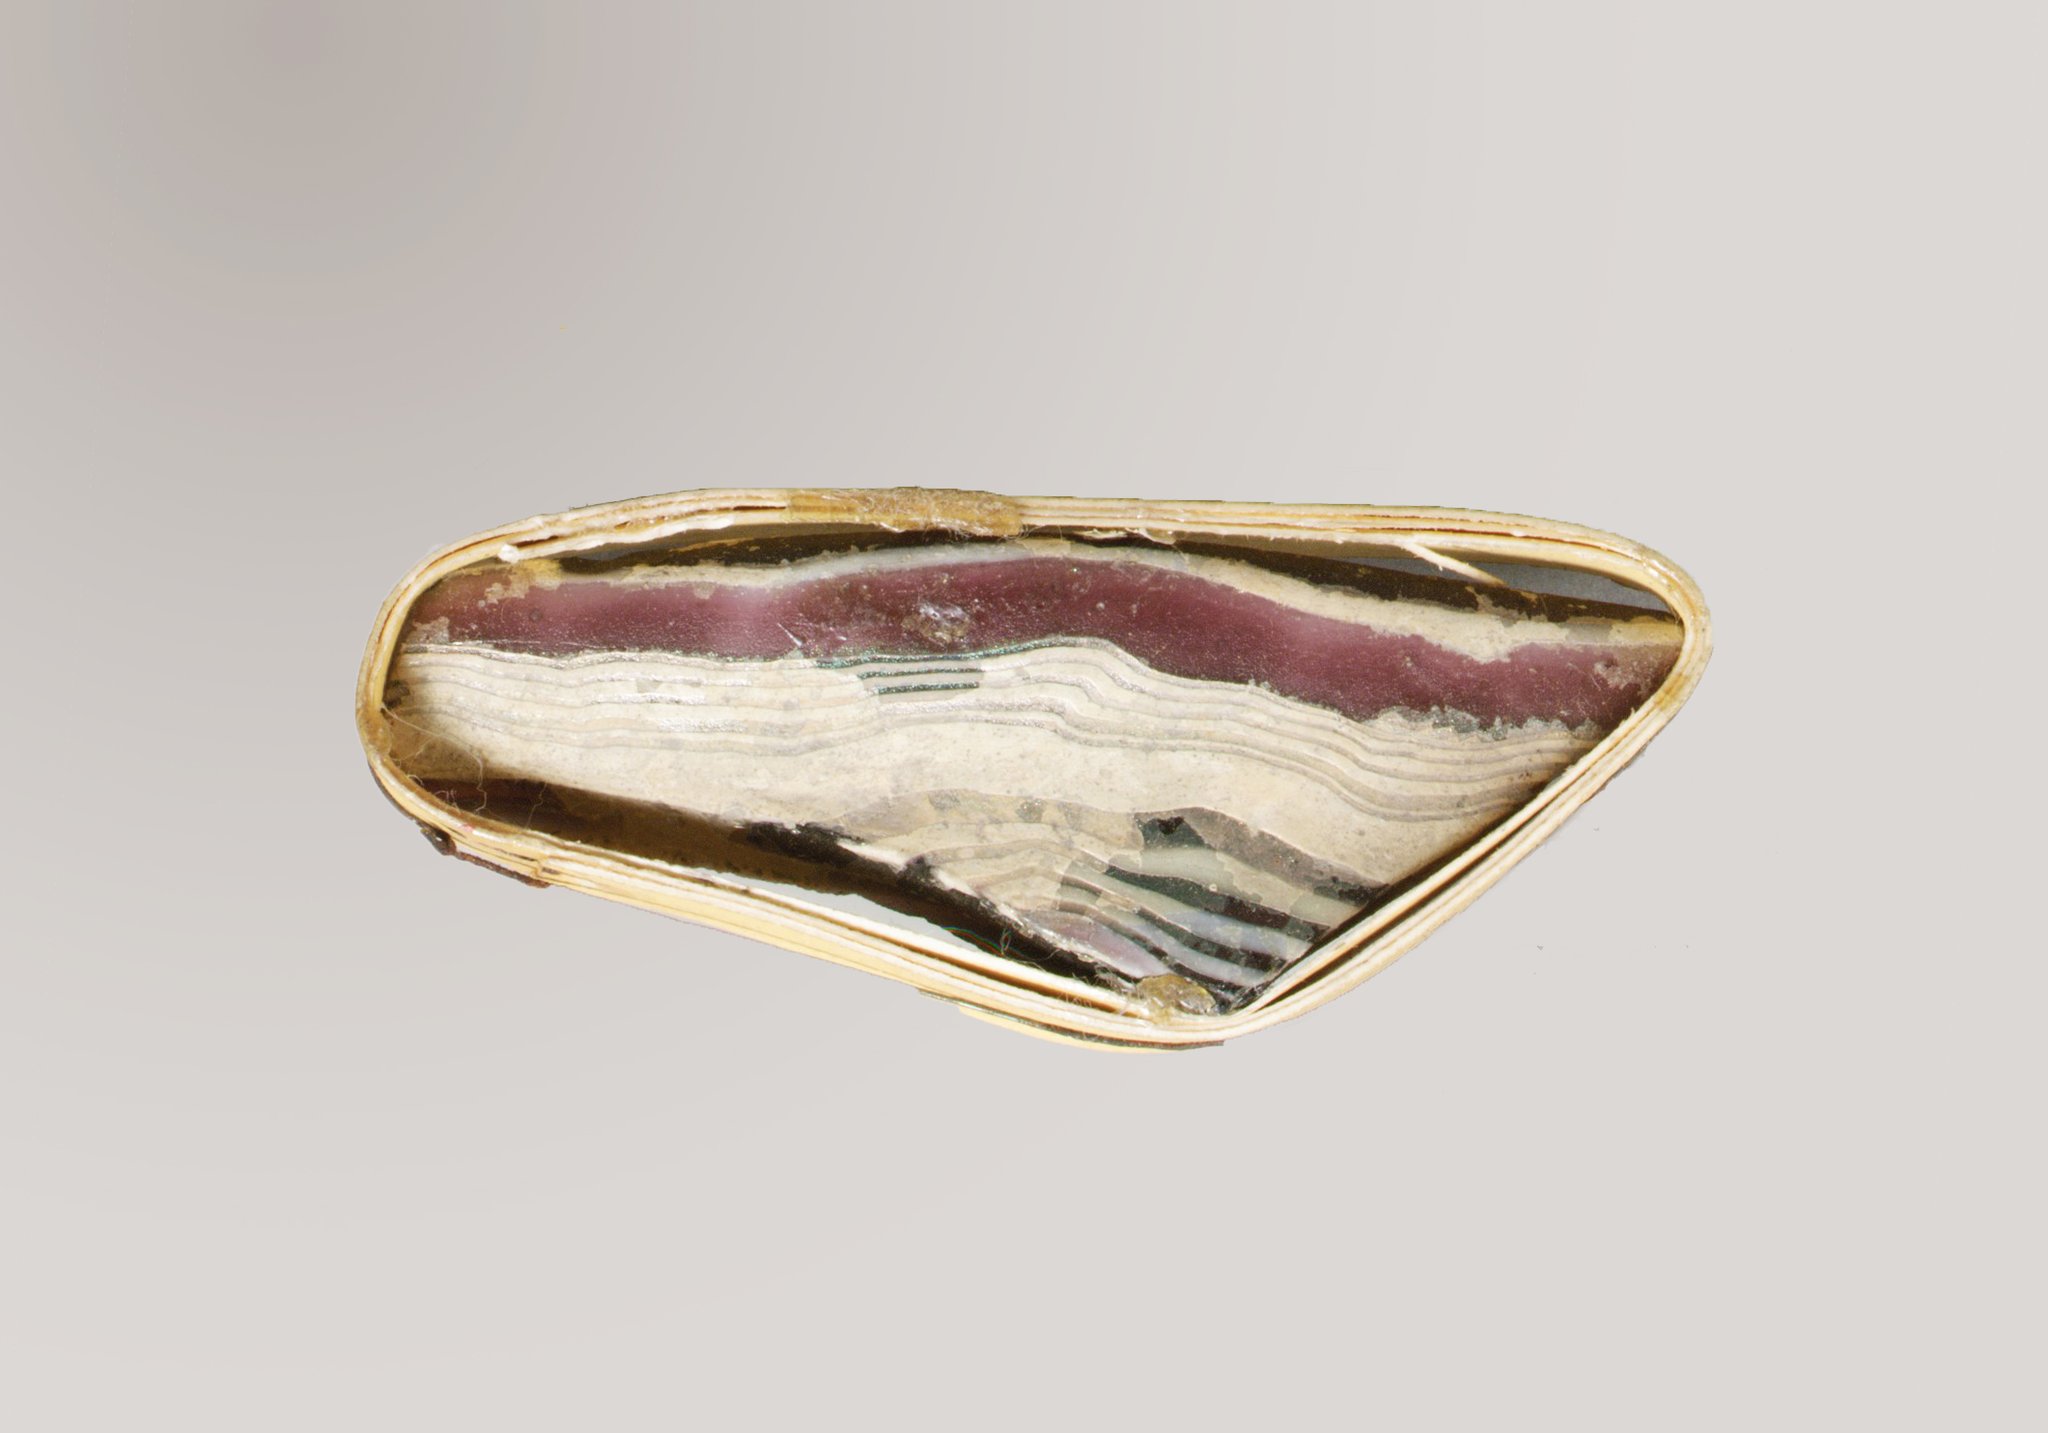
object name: fragment, mosaic bowl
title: Glass mosaic bowl fragment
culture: roman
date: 34 BCE-33 CE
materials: glass